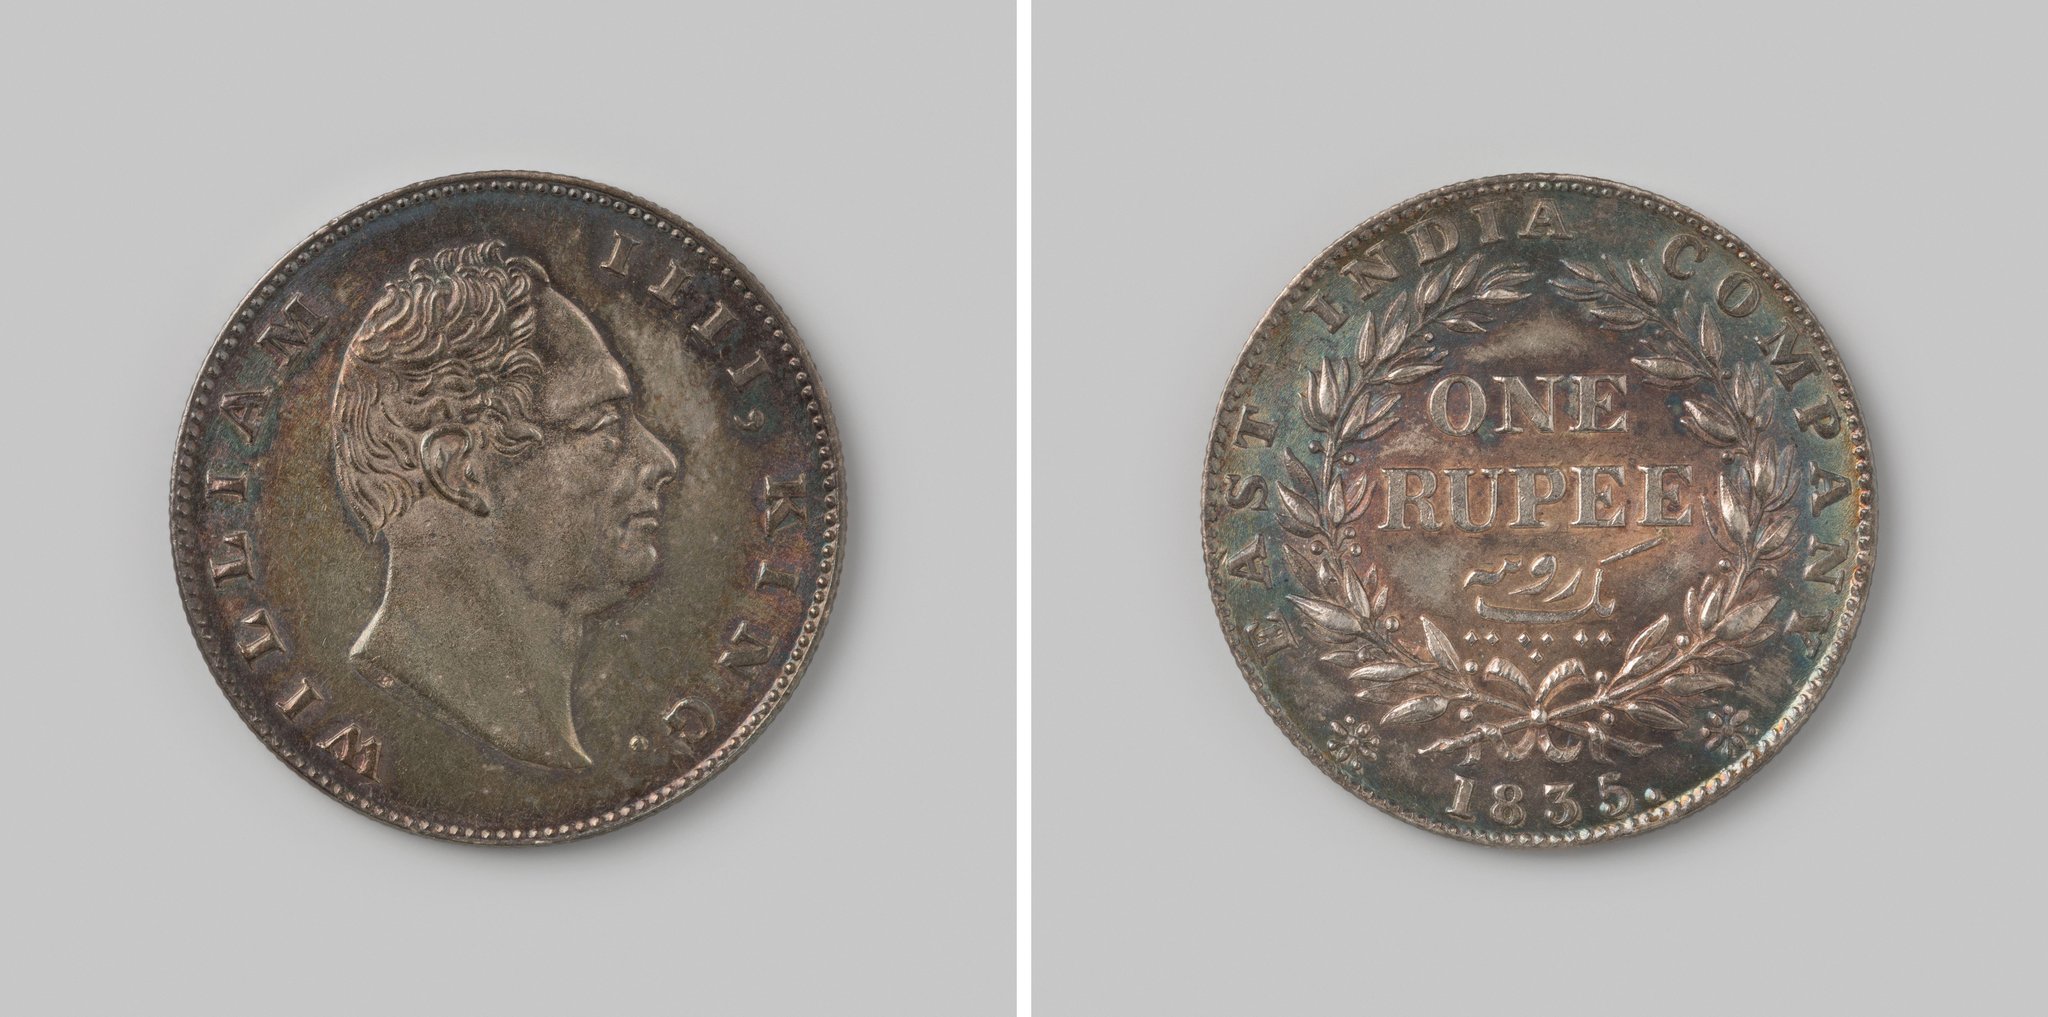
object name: coin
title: India, Engelse Oostindische Compagnie (EIC), op naam van koning William IV, roepie, 1835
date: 1835-1840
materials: silver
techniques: striking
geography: kolkata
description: Zilveren munt. Voorzijde: hoofd van koning William IV naar rechts. Op halsafsnede inwendige letter F [= Forbes, muntmeester te Calcutta]. Keerzijde: tussen twee samengebonden takken in twee regels waarde-aanduiding: one rupee, waaronder in Arabische lettertekens in een regel waarde-aanduiding. Onderaan jaartal. Kartelrand.